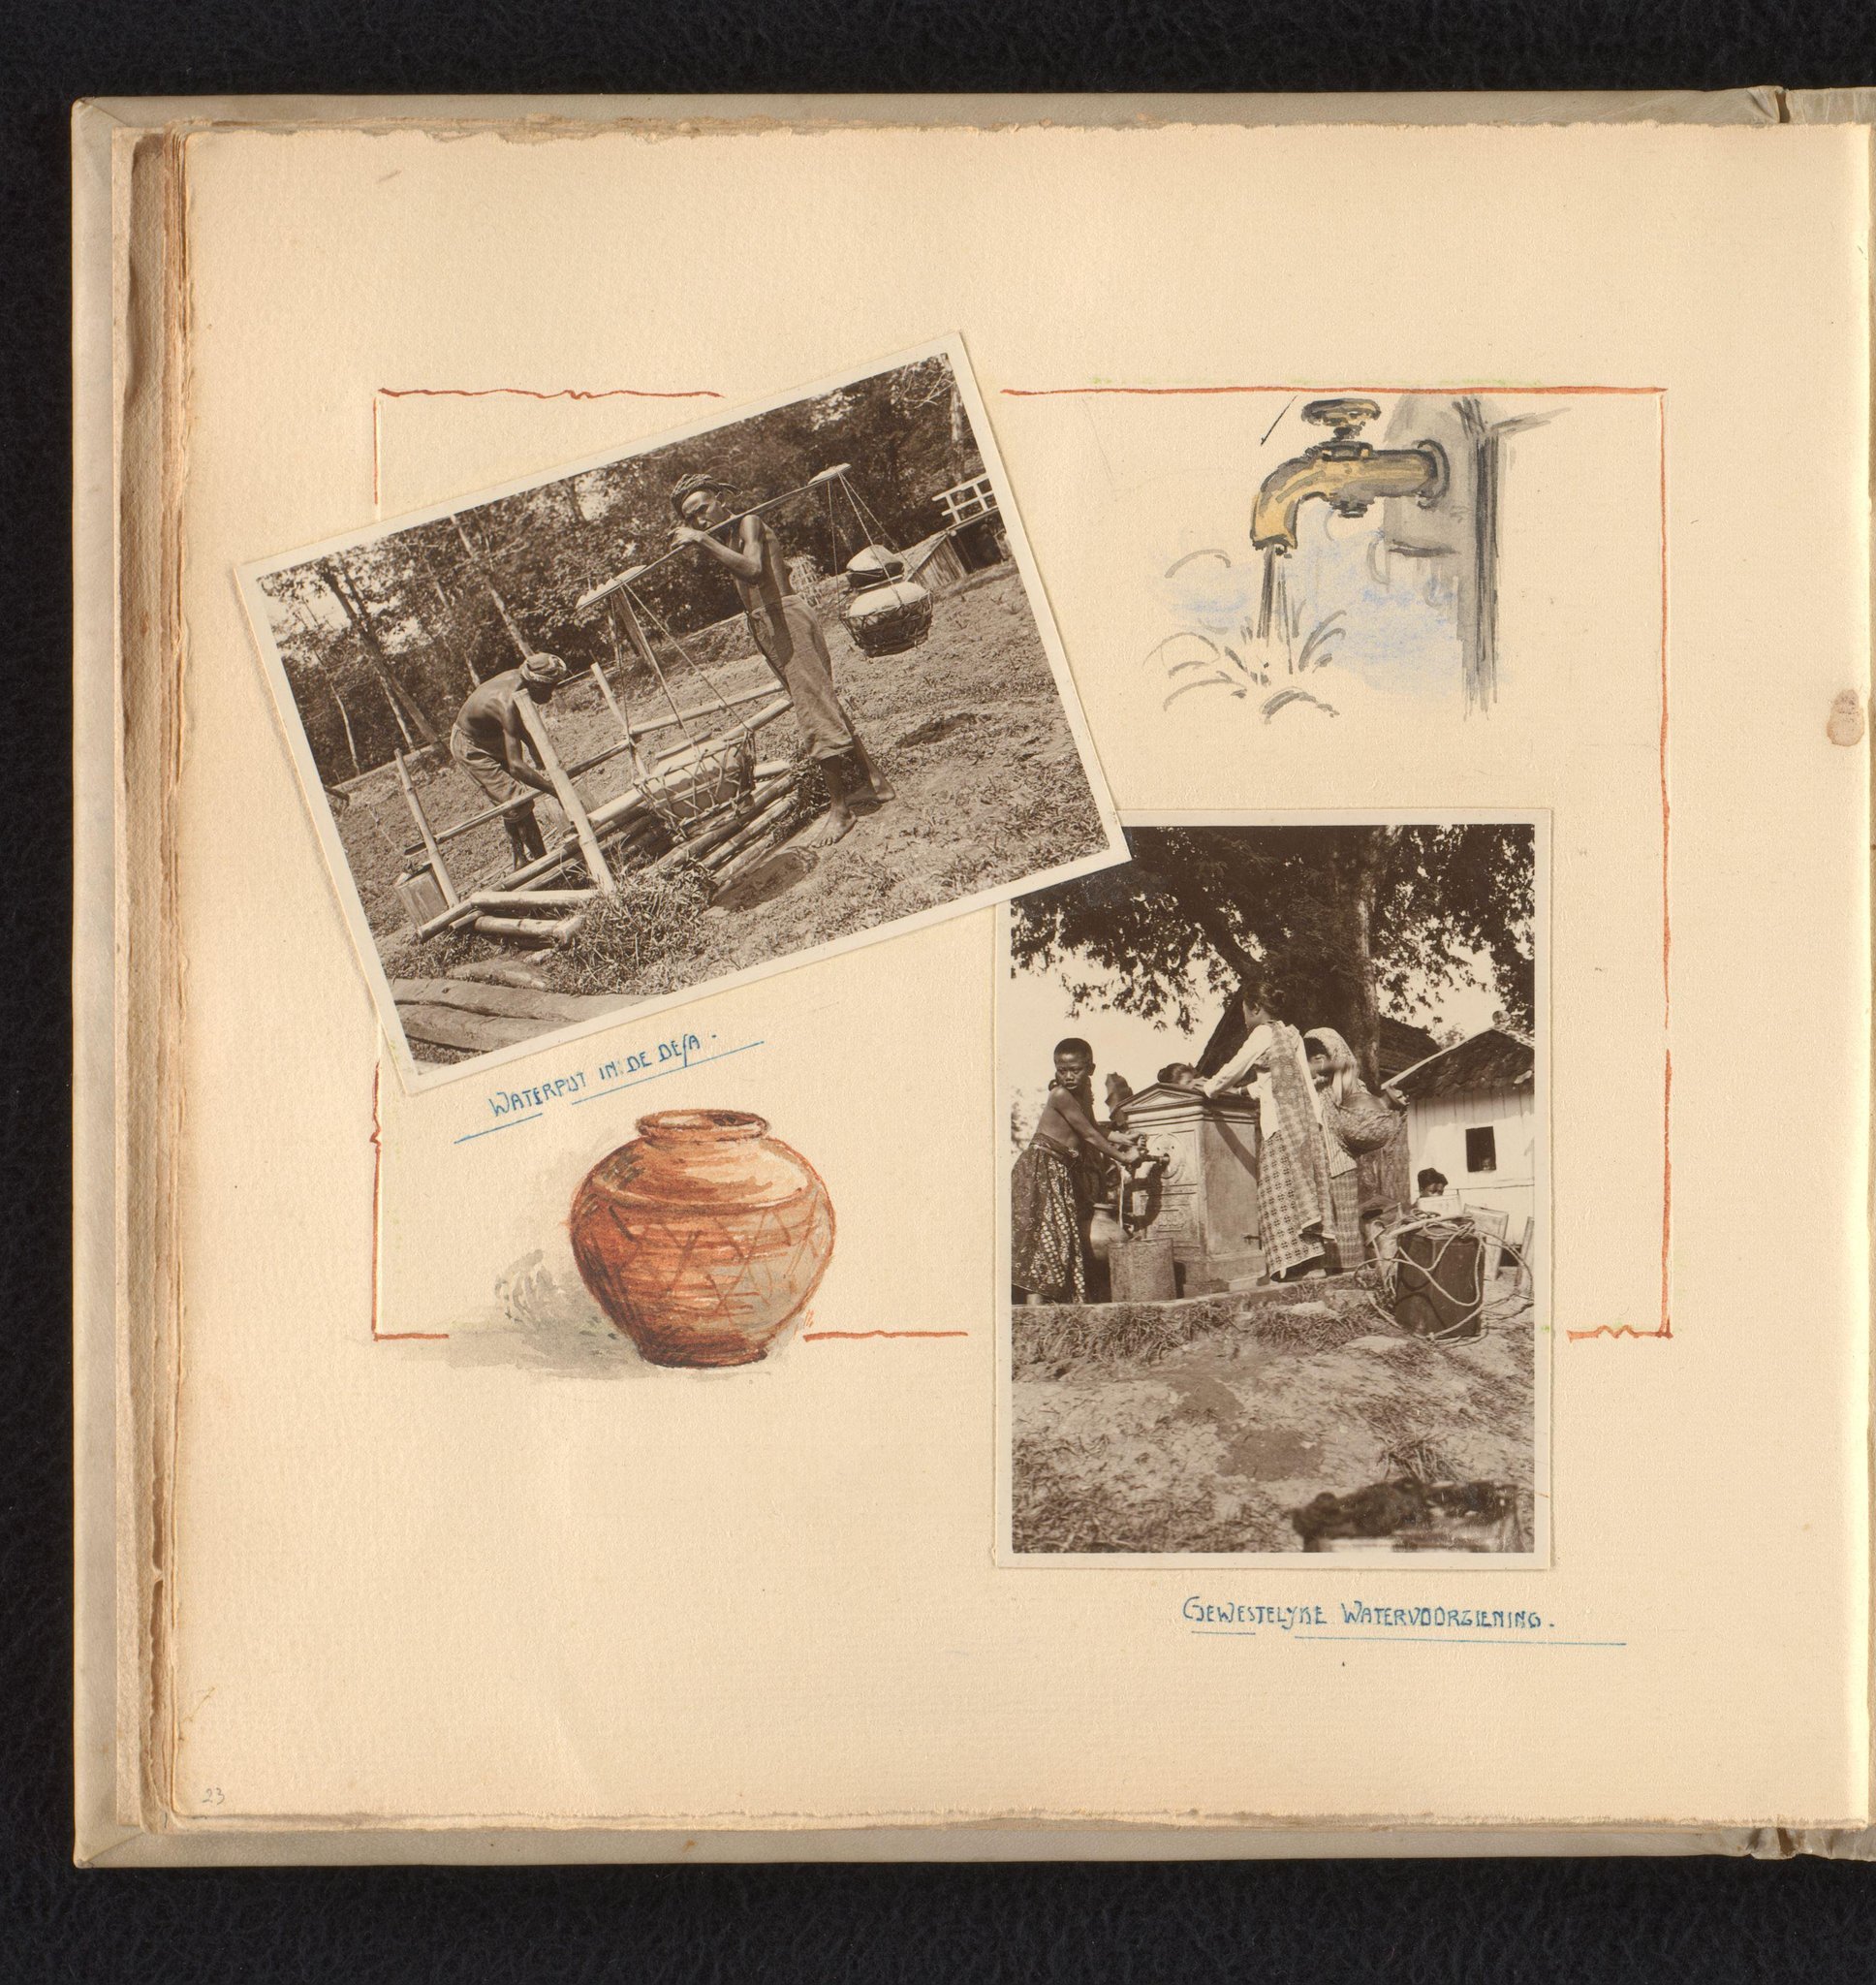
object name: photograph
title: Watervoorziening in Grobogan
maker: Anonymous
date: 1910-1928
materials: paper, photographic support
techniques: drawing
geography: grobogan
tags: water-supply (~ public services)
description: Albumblad met twee foto's van drinkwatervoorziening in Grobogan. Het blad is versierd met een waterkraan en kruik en randwerk om de foto's. Onderdeel van het fotoalbum aangeboden aan J. Habbema door het Binnenlandsch Bestuur Corps van het Regentschap Grobogan, bij het beëindigen van zijn bestuur over het Regentschap, waarschijnlijk in 1928.